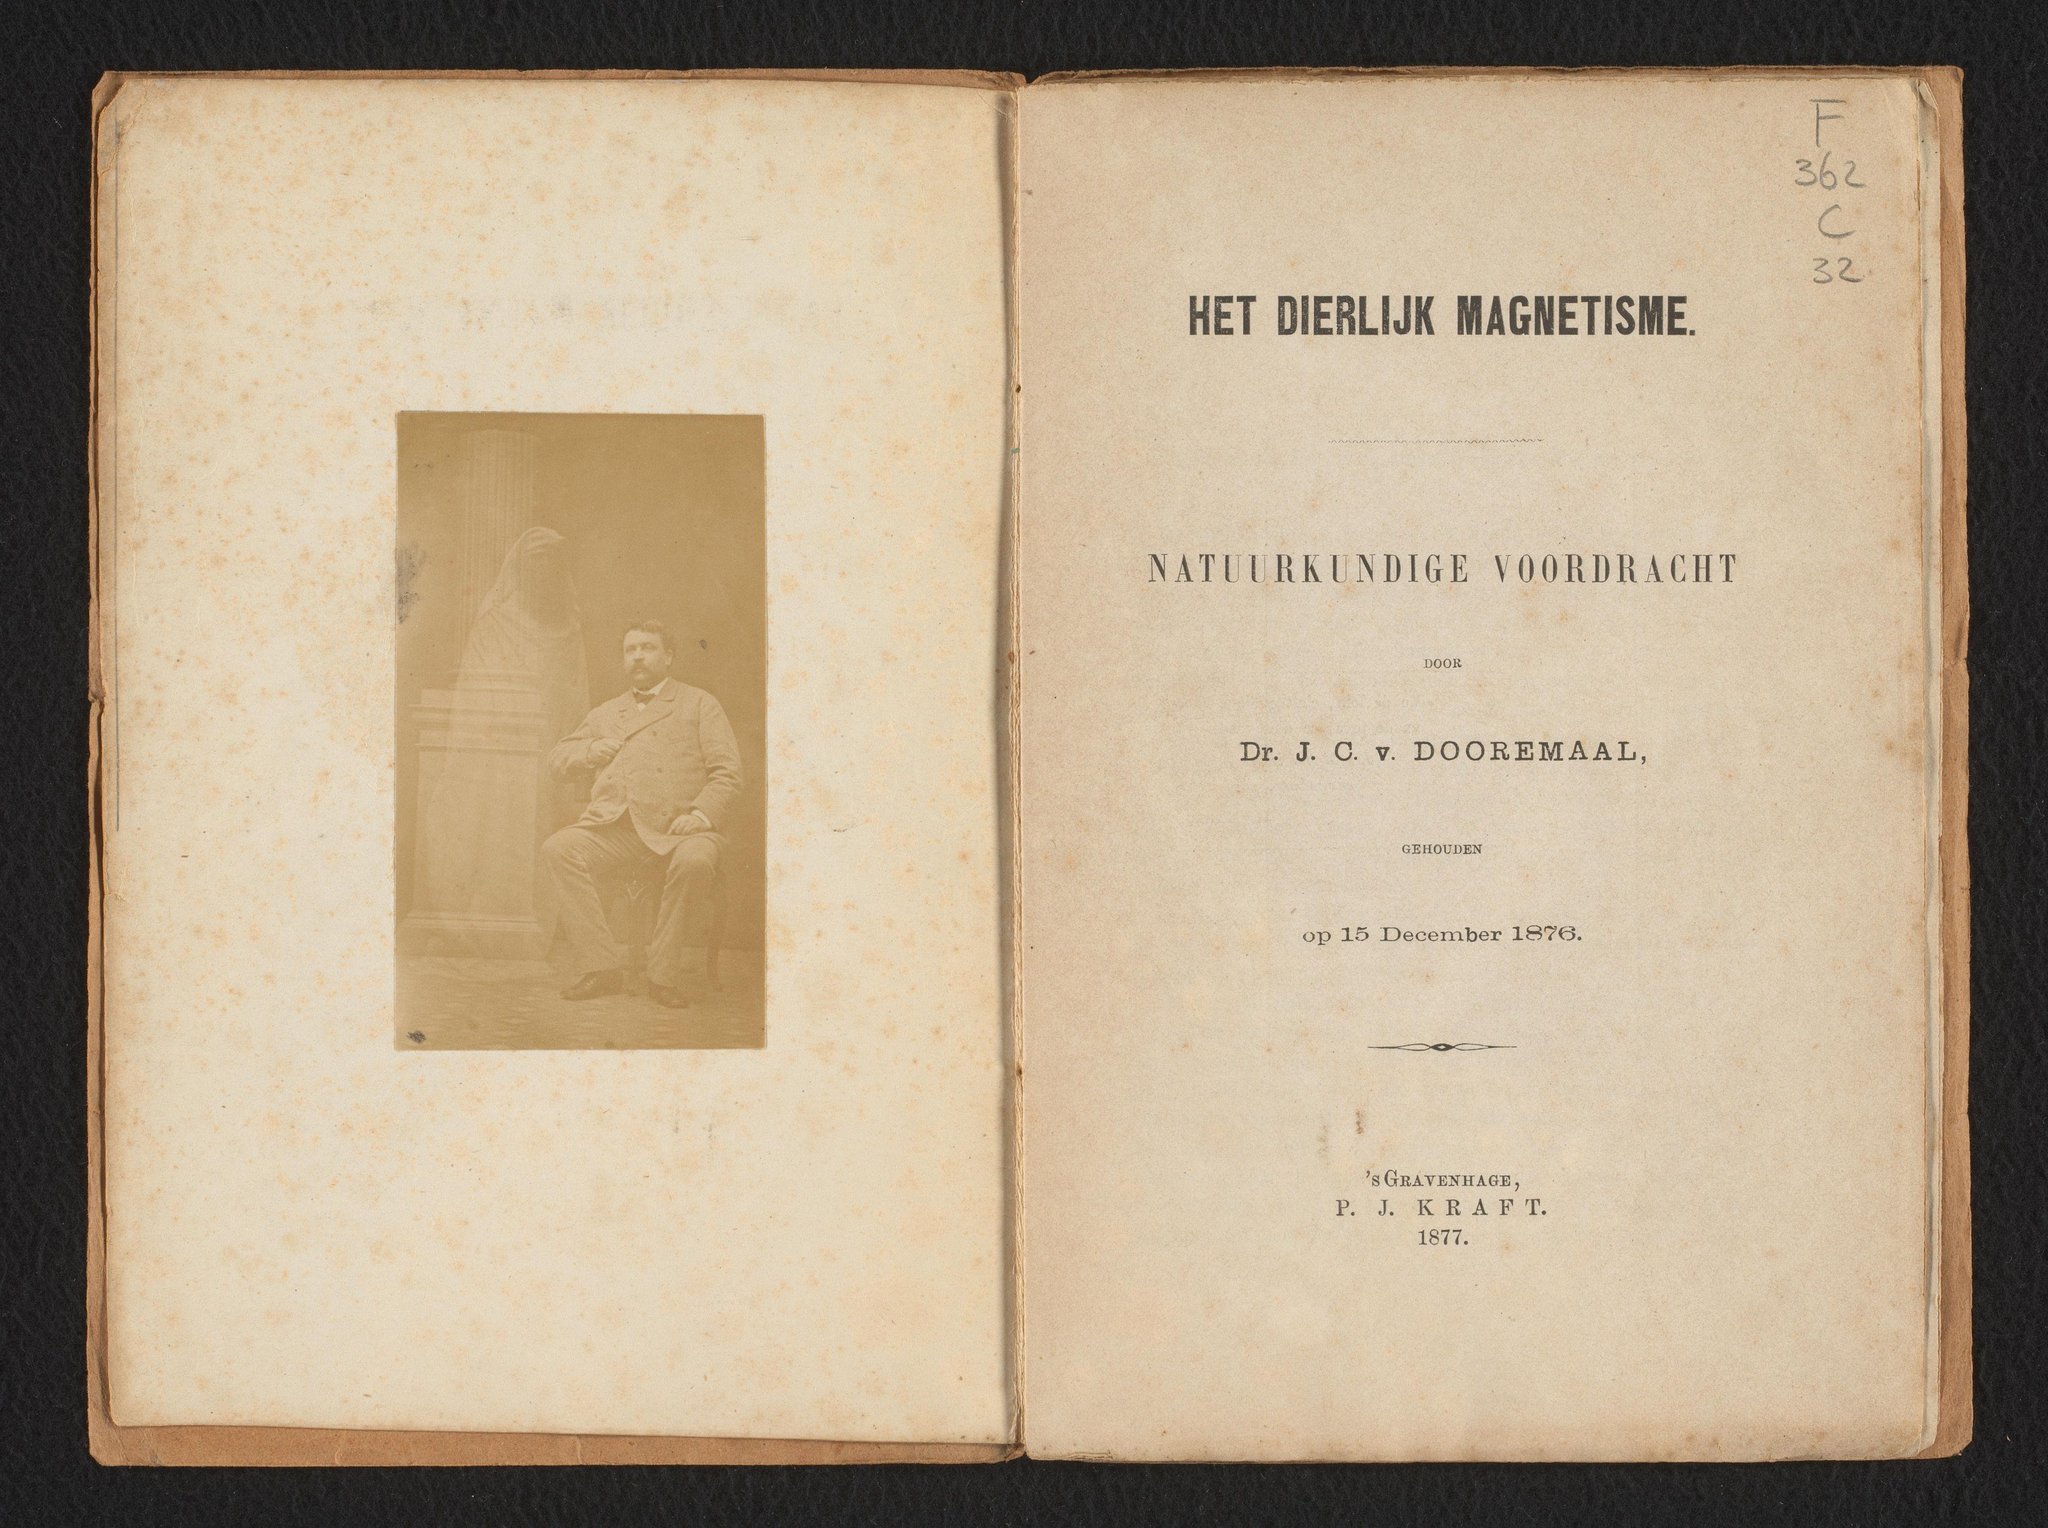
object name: photograph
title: Portret van een onbekende man met naast hem een geestverschijning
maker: Anonymous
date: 1872-1877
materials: paper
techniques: albumen print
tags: historical persons, spirit, ghost